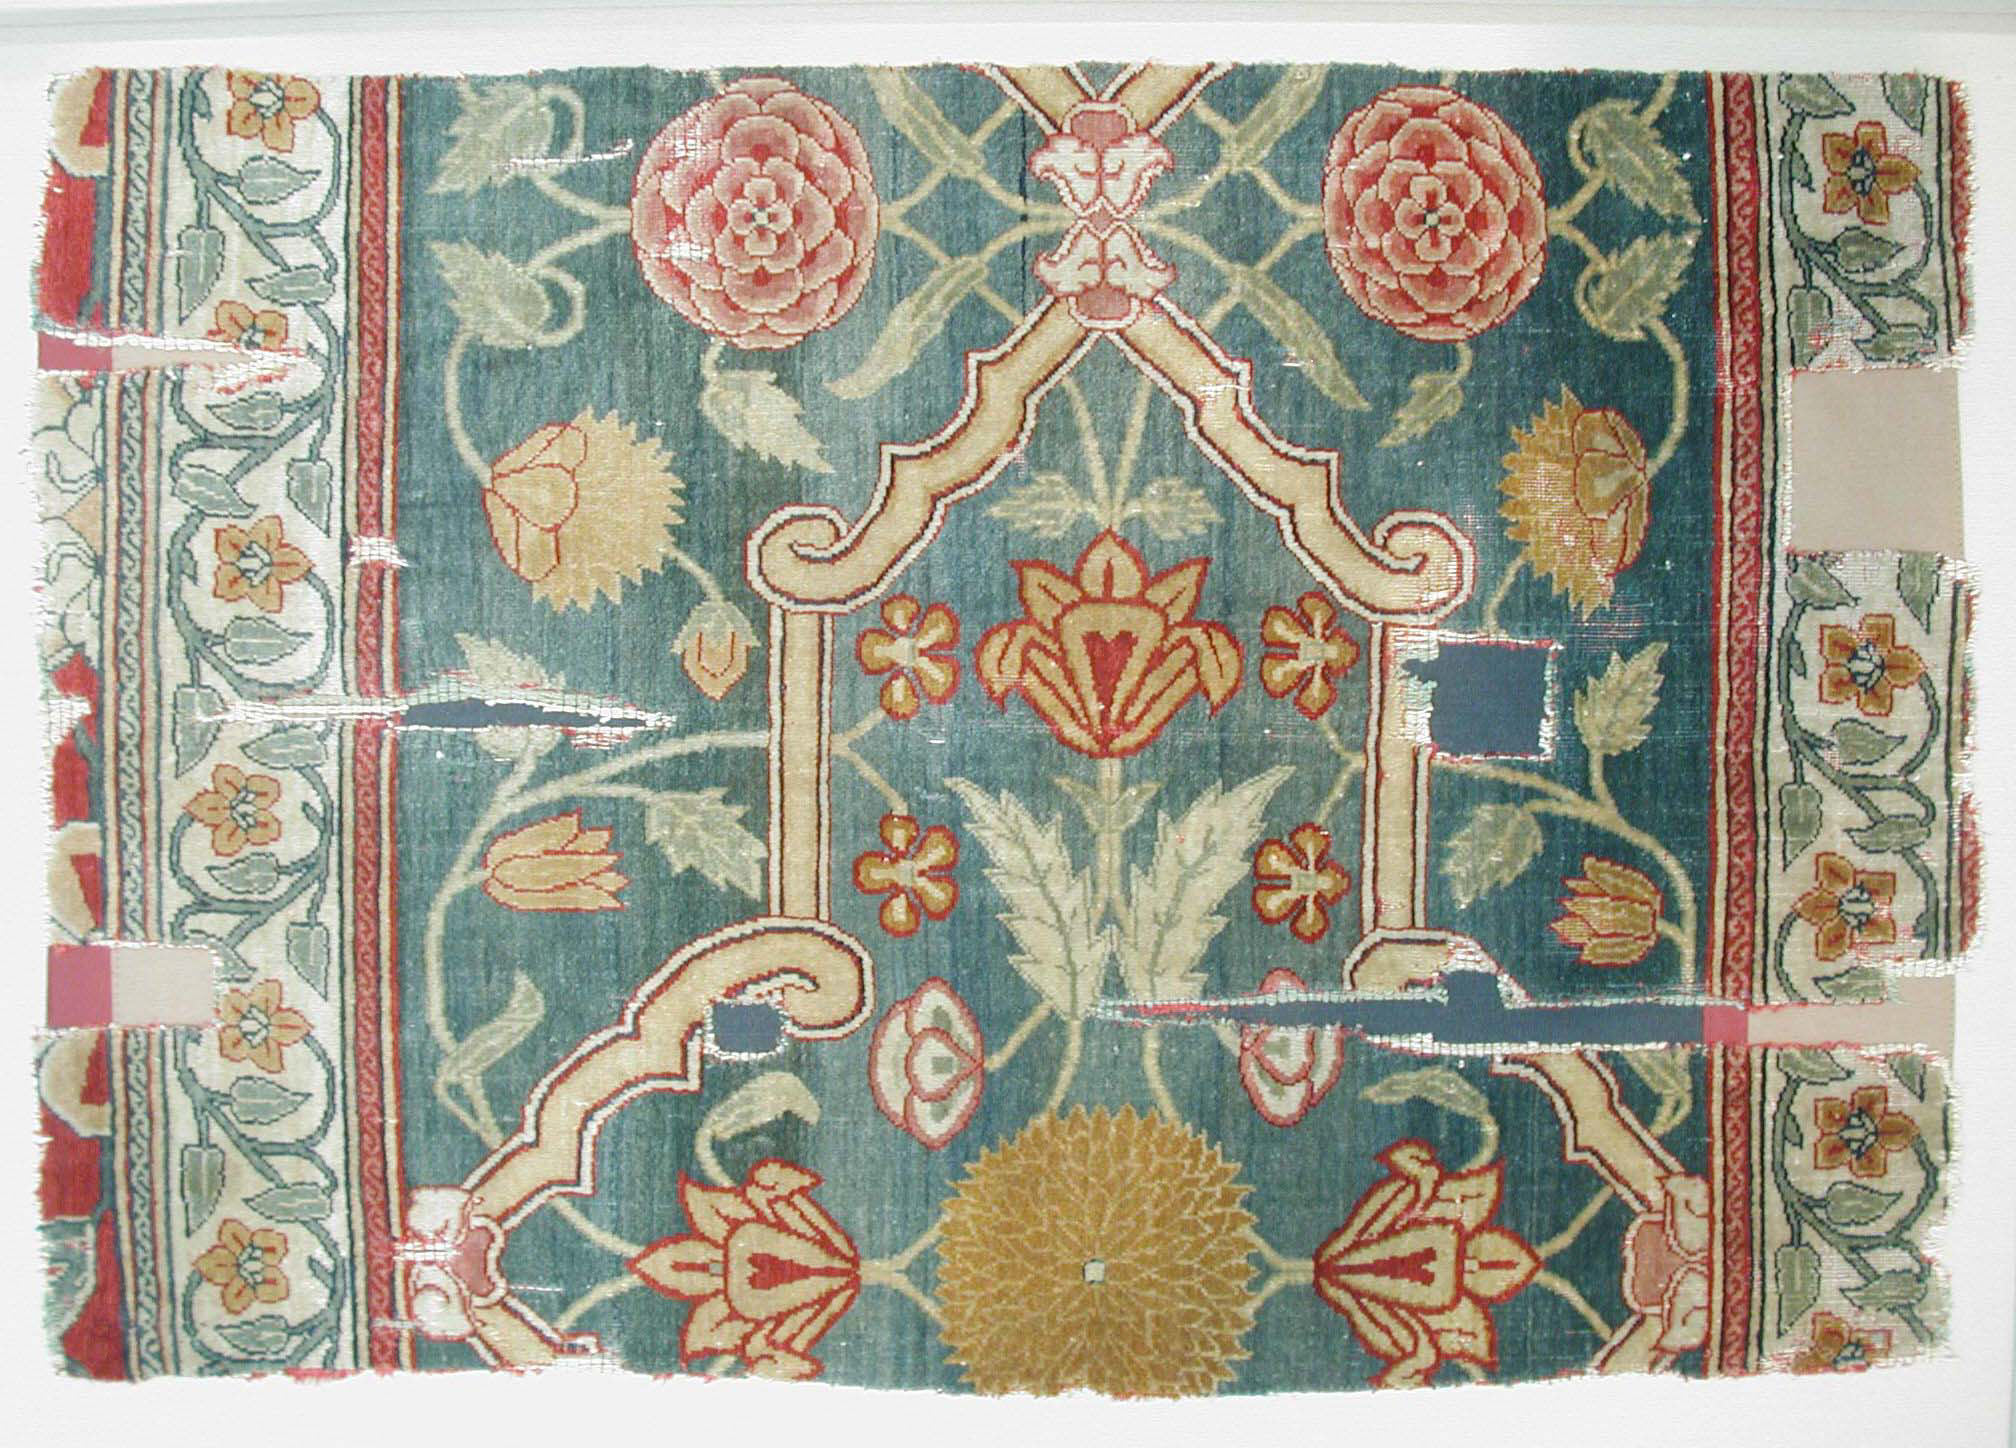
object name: carpet fragment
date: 1651-1675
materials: silk, wool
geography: india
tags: flowers